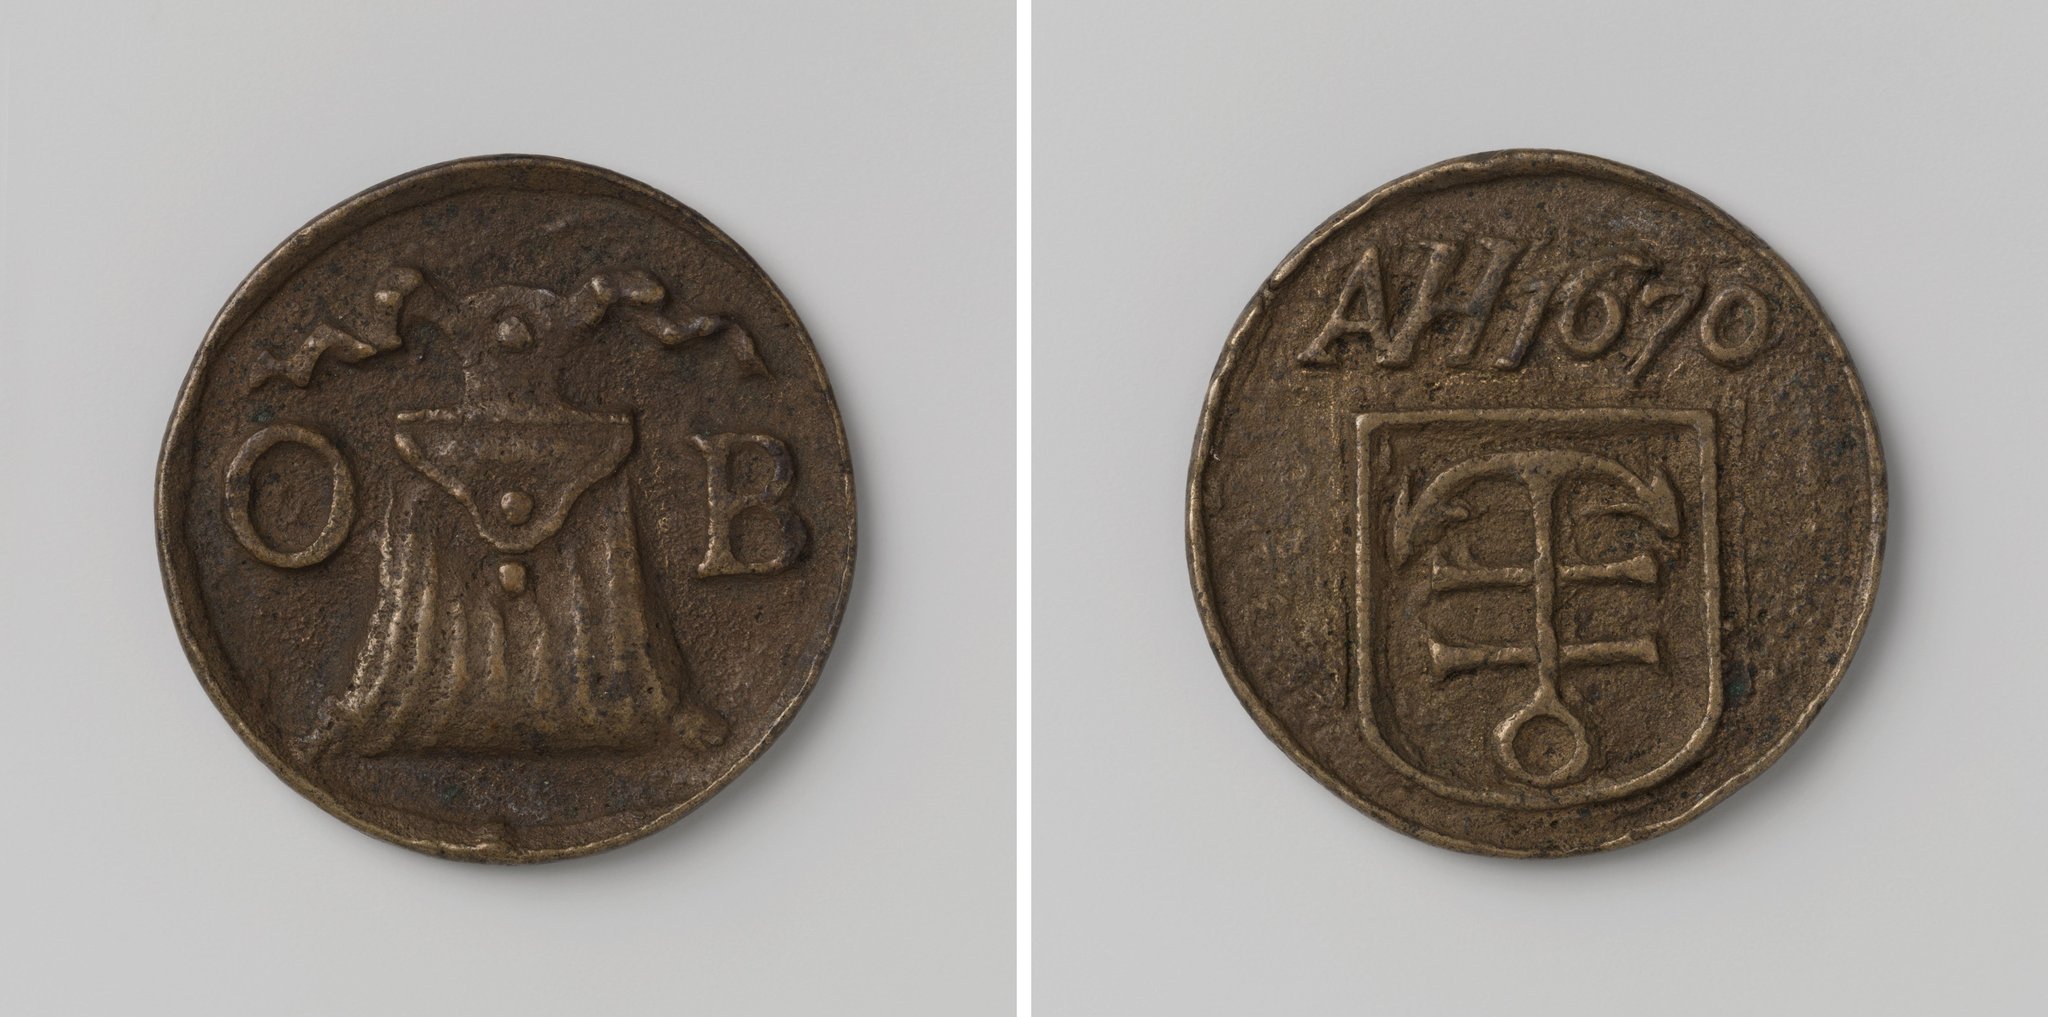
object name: alms token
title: Armenpenning met opschriften O.B. en A.H. 1670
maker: Anonymous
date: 1670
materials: brass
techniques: casting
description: Messing penning. Voorzijde: gesloten, gevulde beurs aan lint tussen letters O en B. Keerzijde: opschrift A.H. 1670 boven schild met omgekeerd anker. Vermoedelijk een armenpenning.